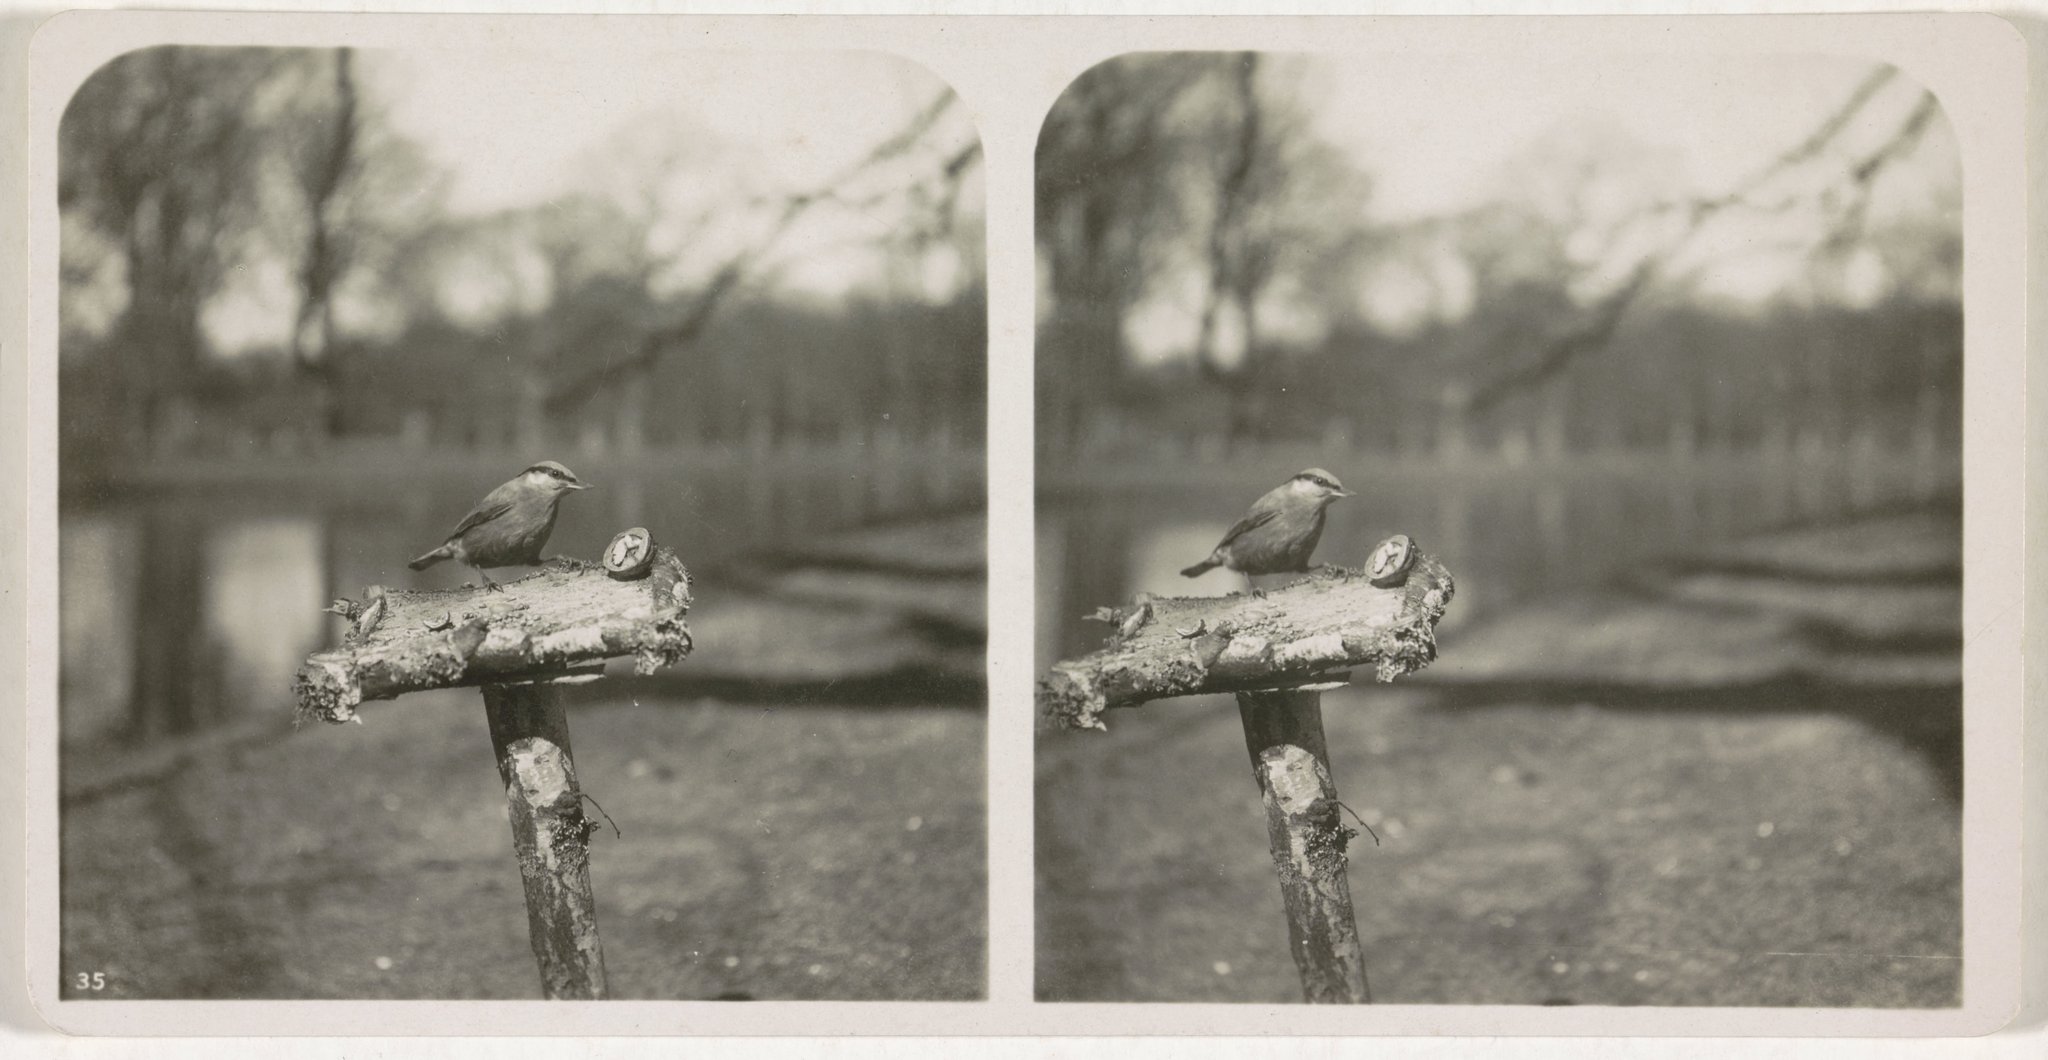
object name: stereograph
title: Les oiseaux et leurs nids / 2e Série Les oiseaux chanteurs (Suite).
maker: adolphe burdet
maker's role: fotograaf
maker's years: 1860-1940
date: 1870-1940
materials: photographic support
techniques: gelatin silver print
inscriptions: label: ‘35 / Sitta caesia Meyer u. Wolf / Sittelle / Boomklever...’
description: Linksonder op de foto links staat het nummer 35. Uit serie van 25 stereofoto's.